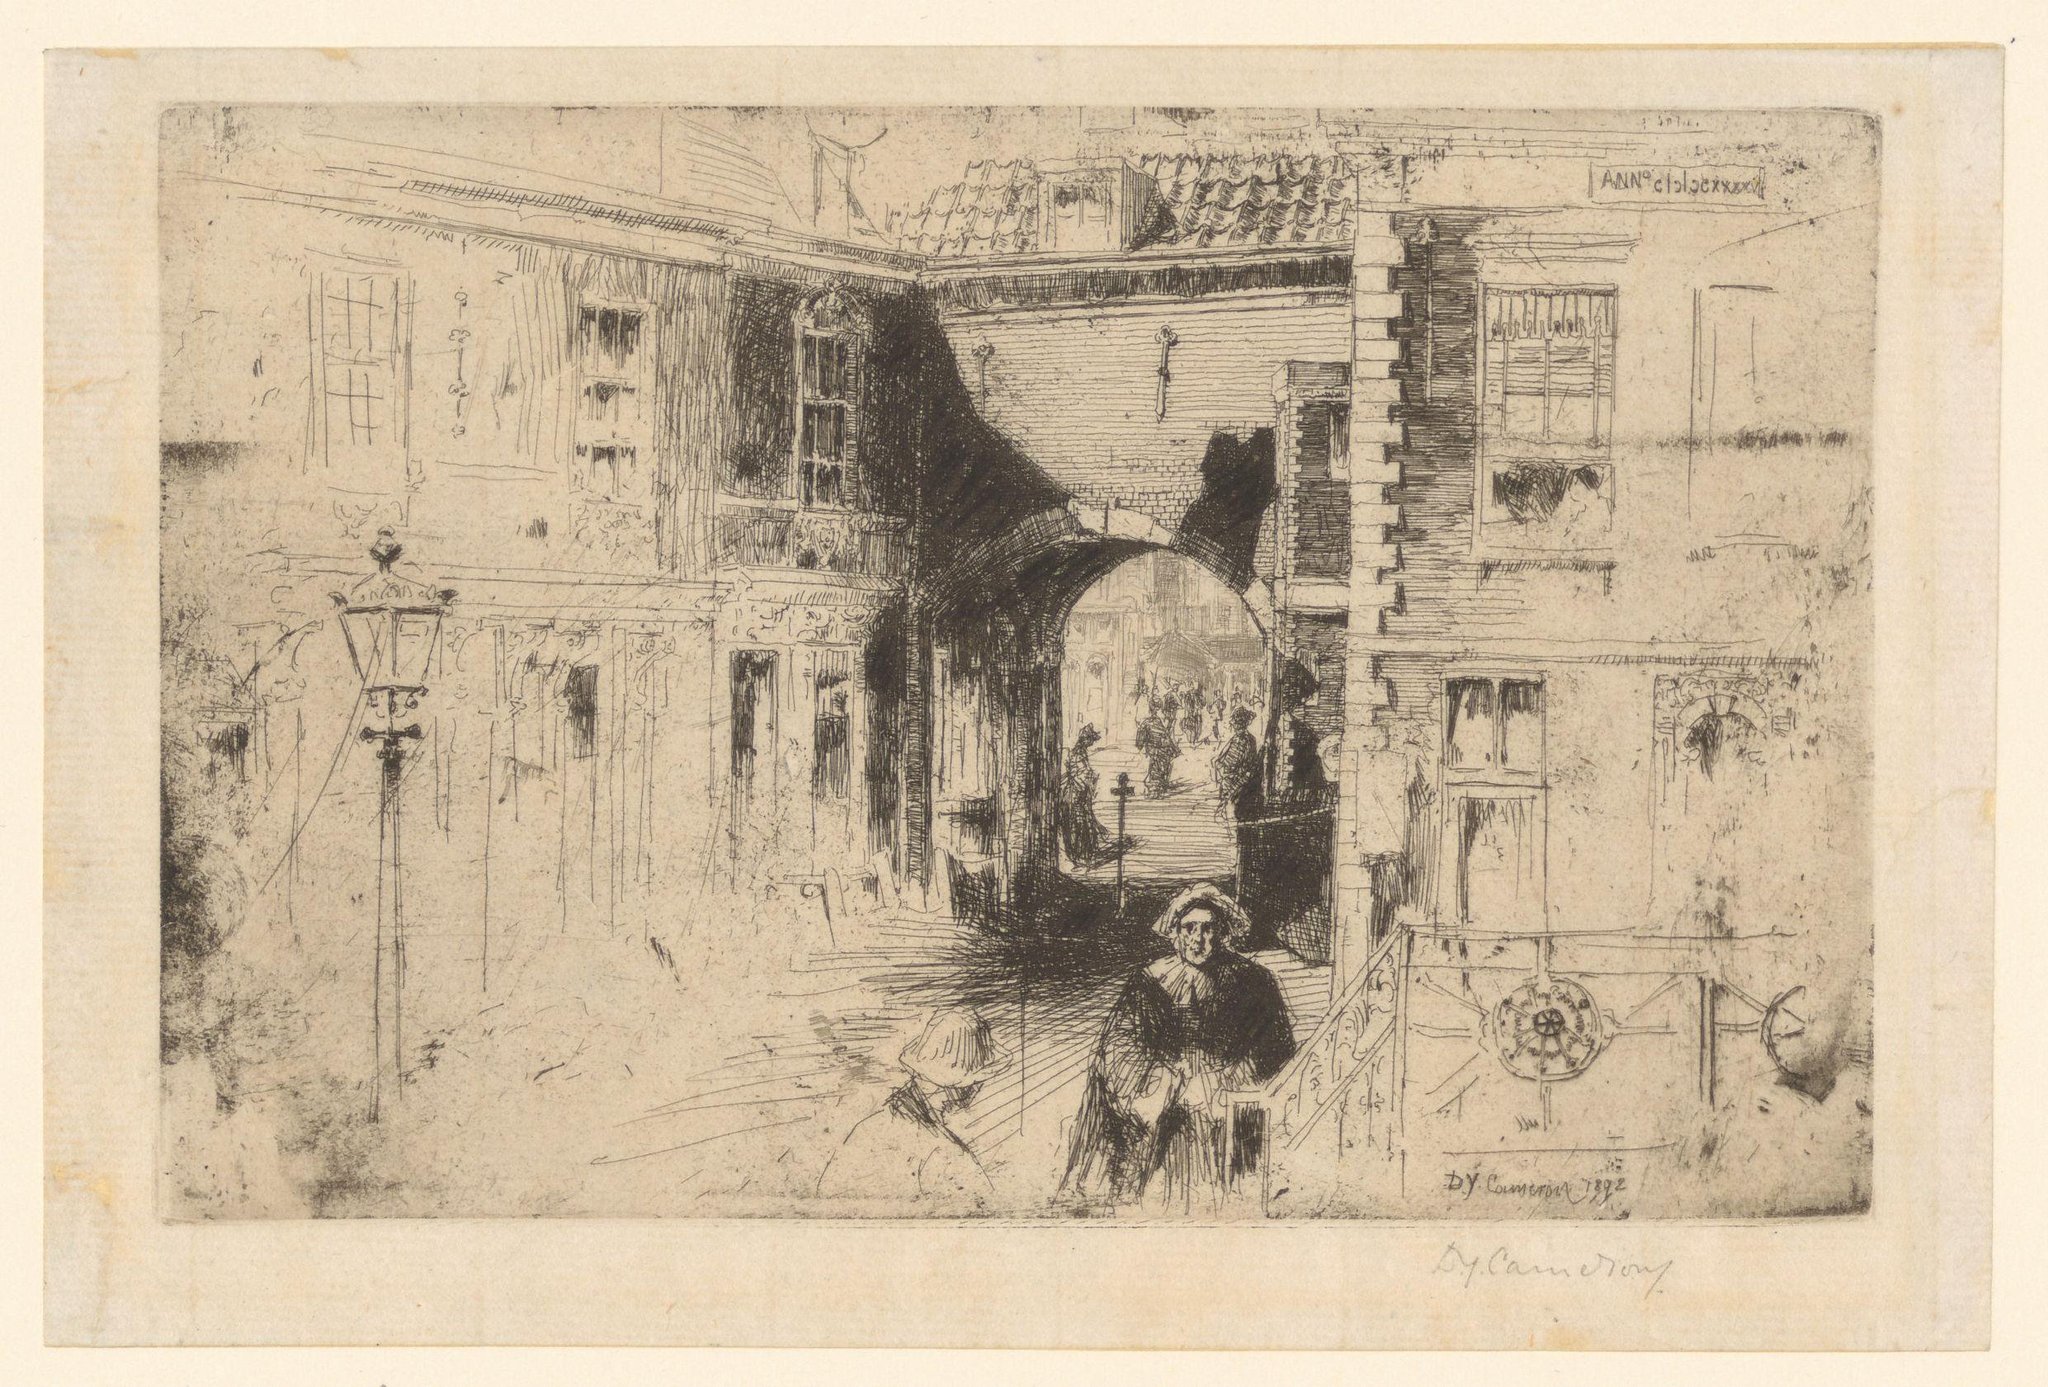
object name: print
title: Etchings in North Holland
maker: david young cameron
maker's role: draughtsman, print maker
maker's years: 1865-1945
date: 1892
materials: paper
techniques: drypoint, etching, intaglio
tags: gate, entrance, street (+ city(-scape) with figures, staffage)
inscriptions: collector's mark: Lugt 2228, collector's mark: Lugt 2760